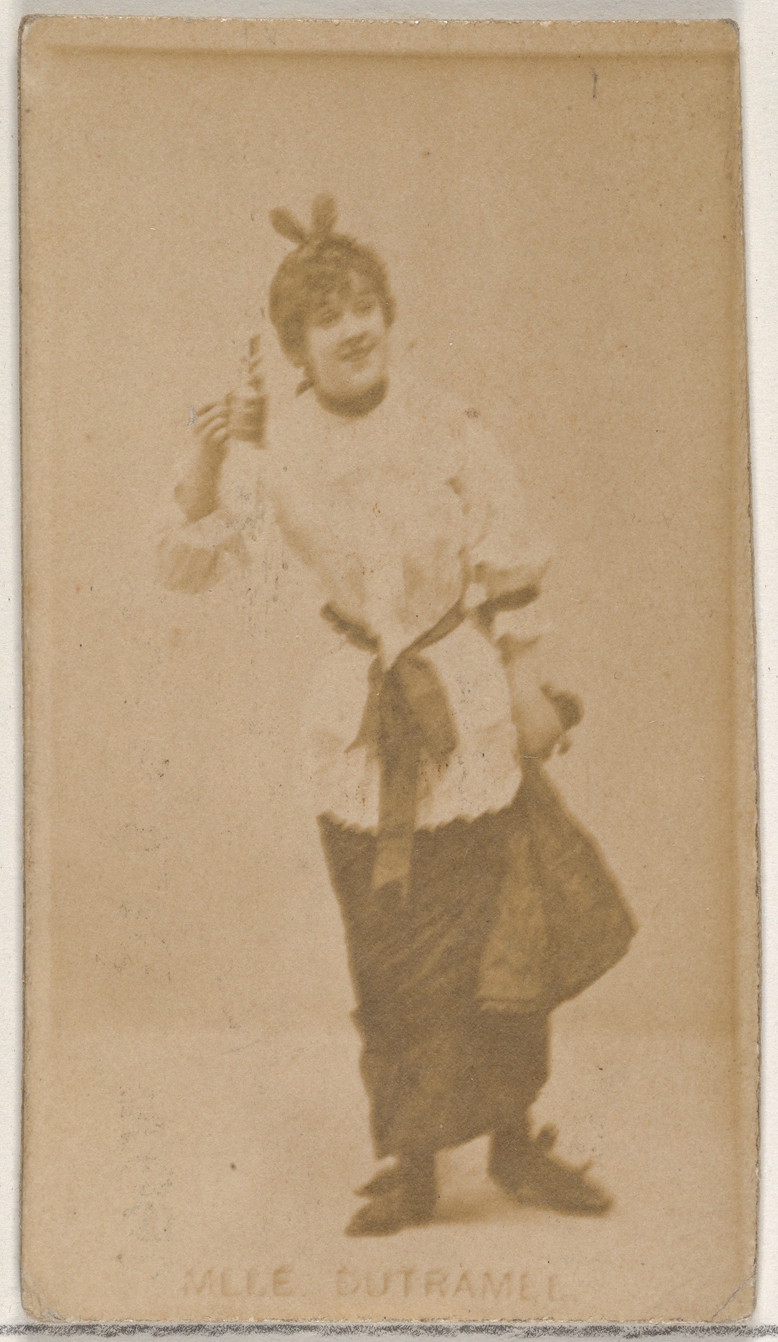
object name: photograph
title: Mlle. Dutramel, from the Actors and Actresses series (N45, Type 8) for Virginia Brights Cigarettes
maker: allen & ginter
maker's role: publisher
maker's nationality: american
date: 1888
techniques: albumen silver print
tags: portraits,women,actresses